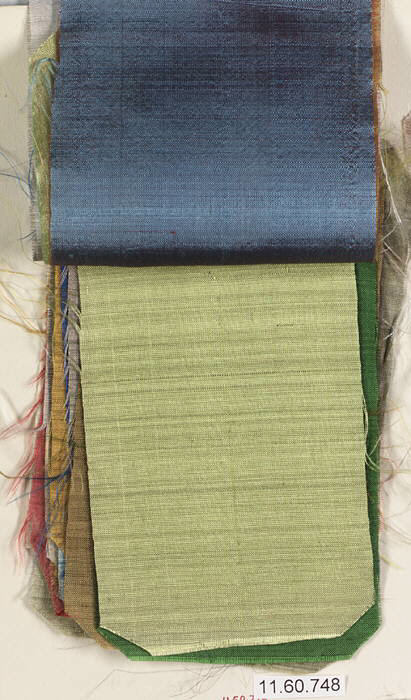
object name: sample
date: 1801-1833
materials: silk